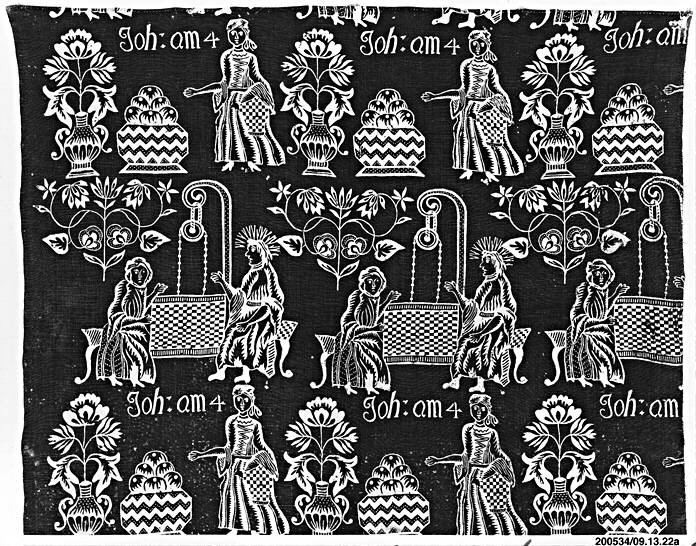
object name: panel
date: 1601-1700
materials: linen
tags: human figures,flowers